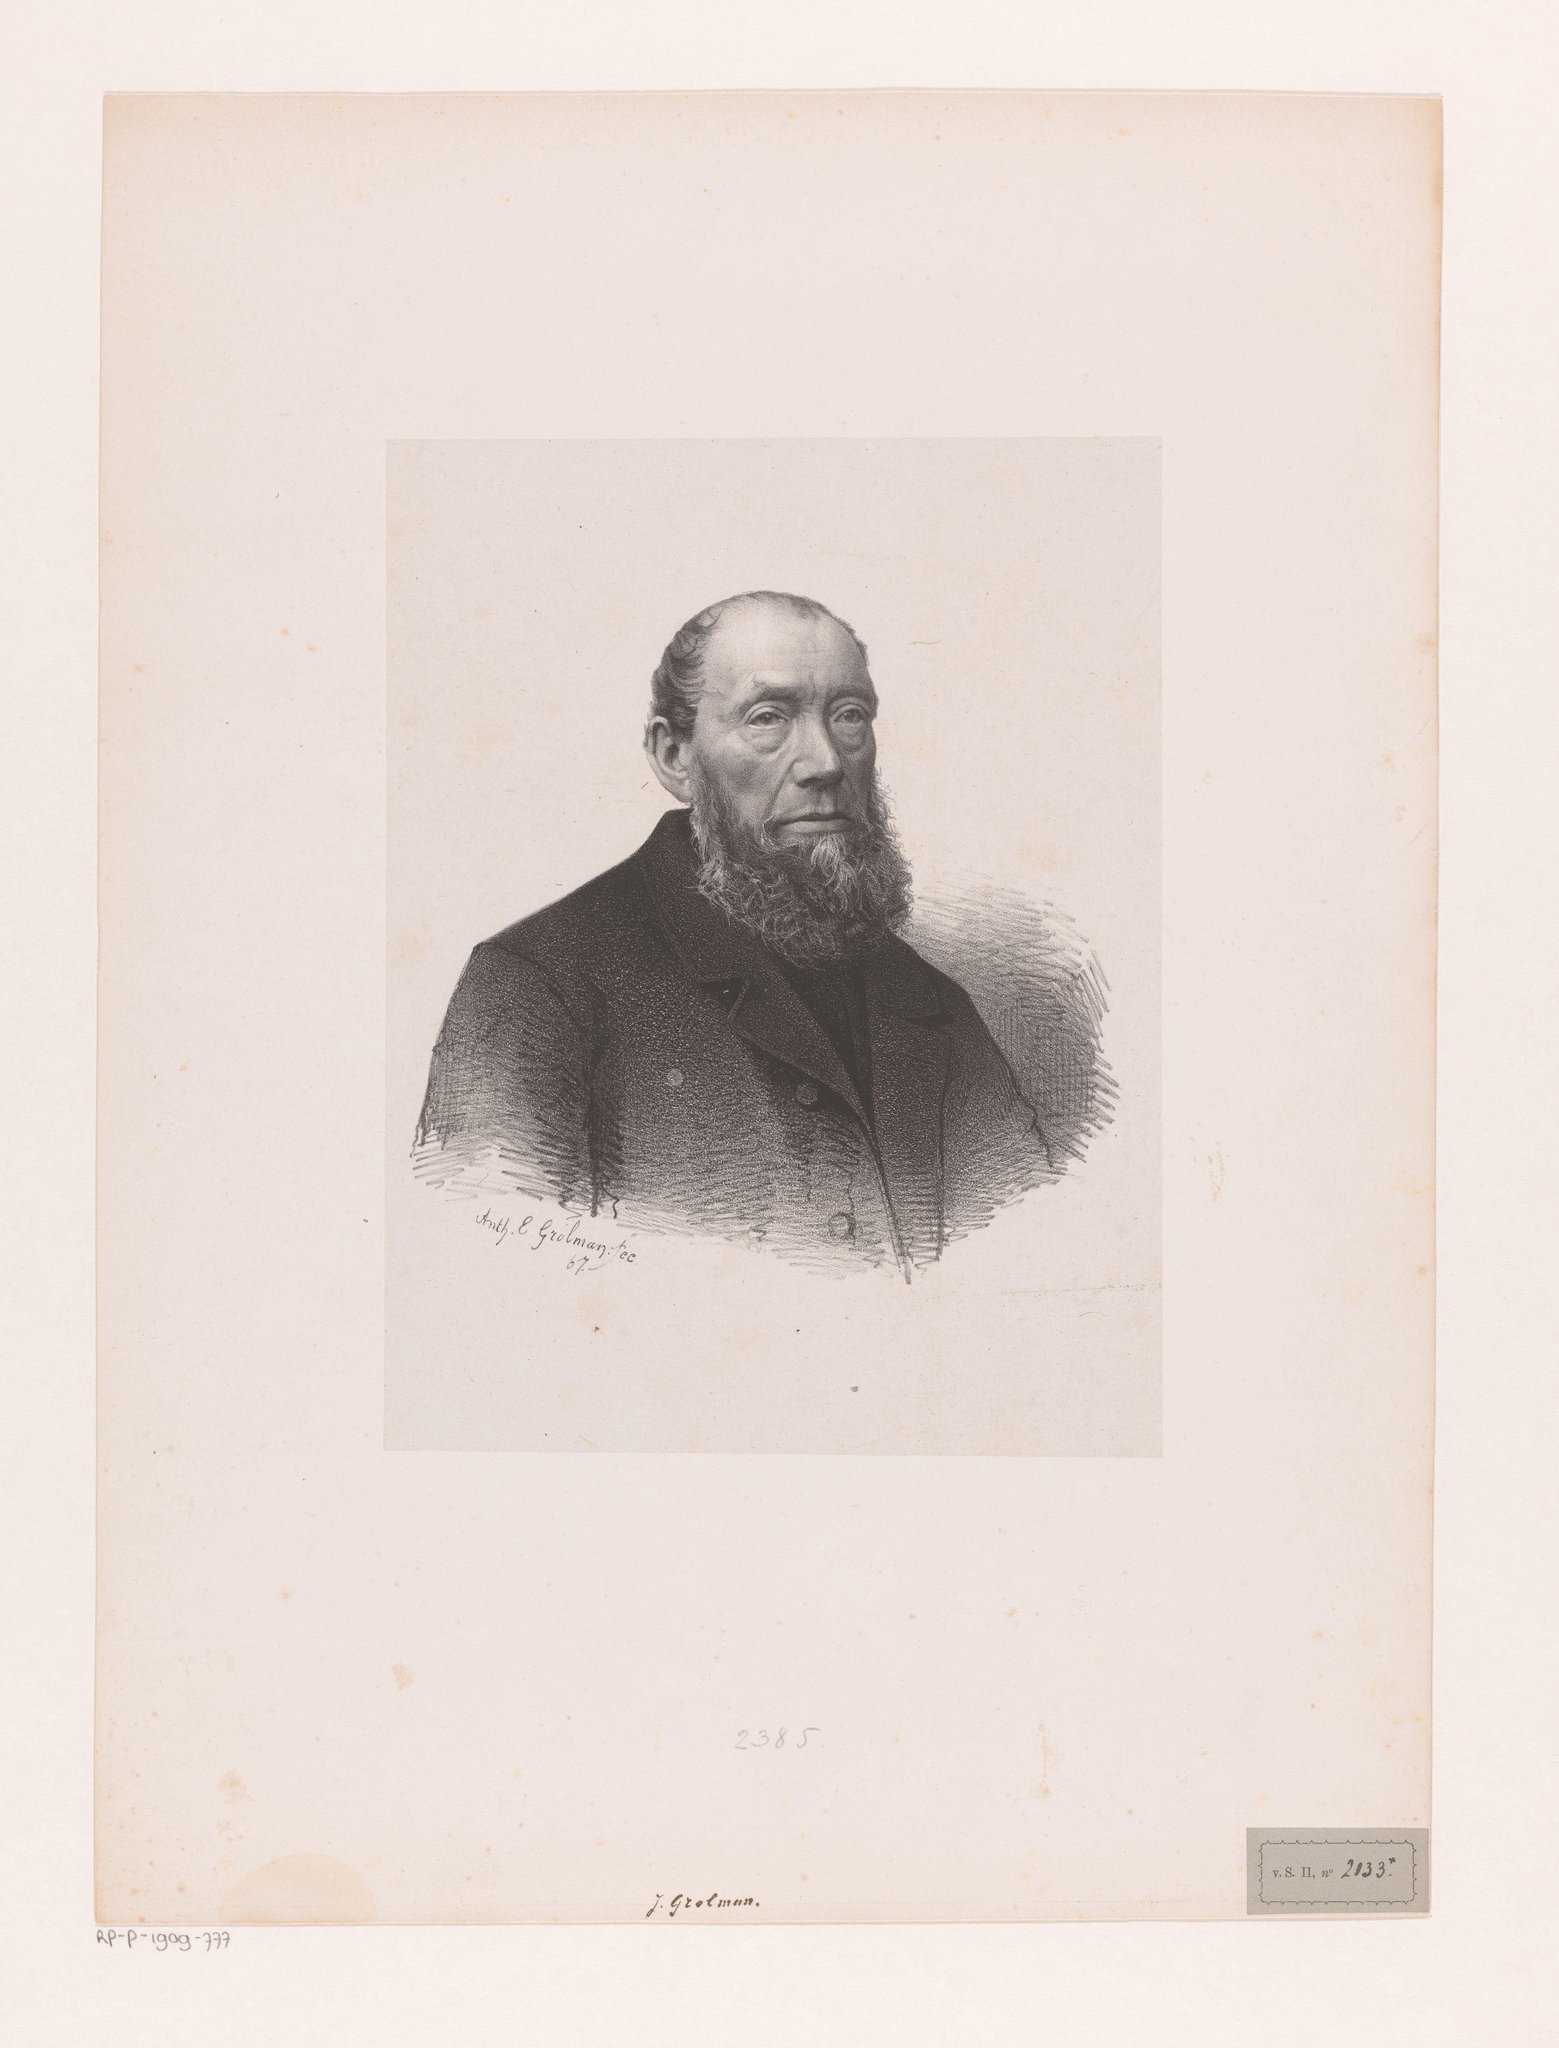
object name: print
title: Portret van een onbekende man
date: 1867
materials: paper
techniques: lithograph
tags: historical persons (+ head (and shoulders) (portrait))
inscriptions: collector's mark: Lugt 2228